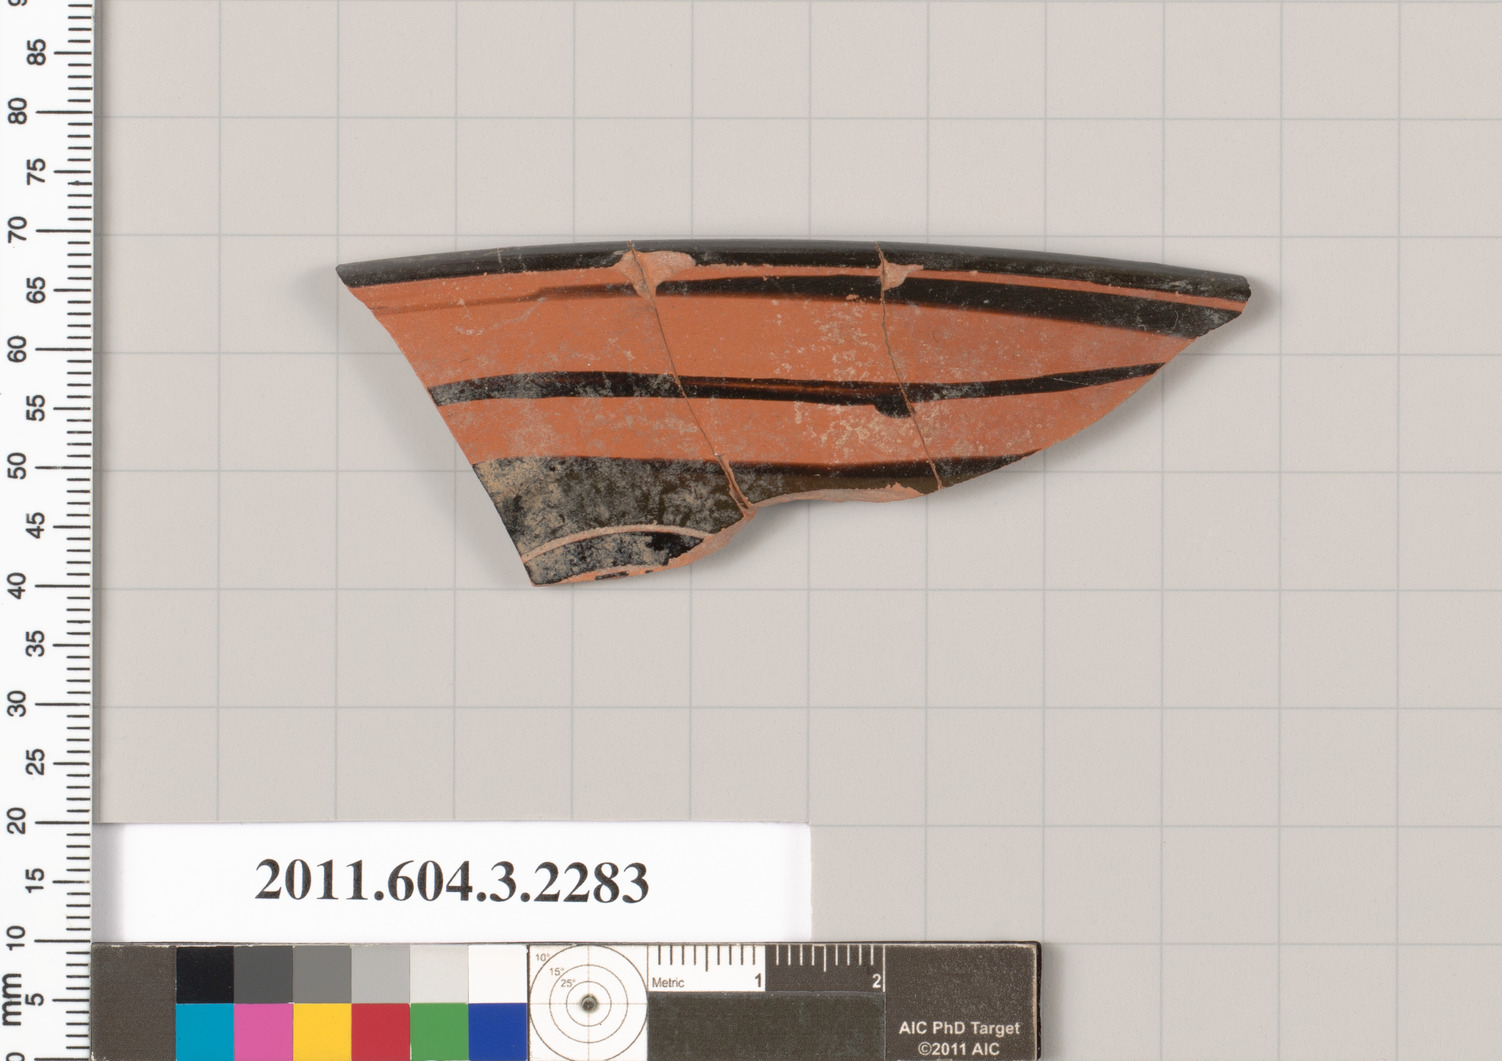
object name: kylix fragment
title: Terracotta rim fragment of a kylix: eye-cup (drinking cup)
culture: greek, attic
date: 525-501 BCE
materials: terracotta